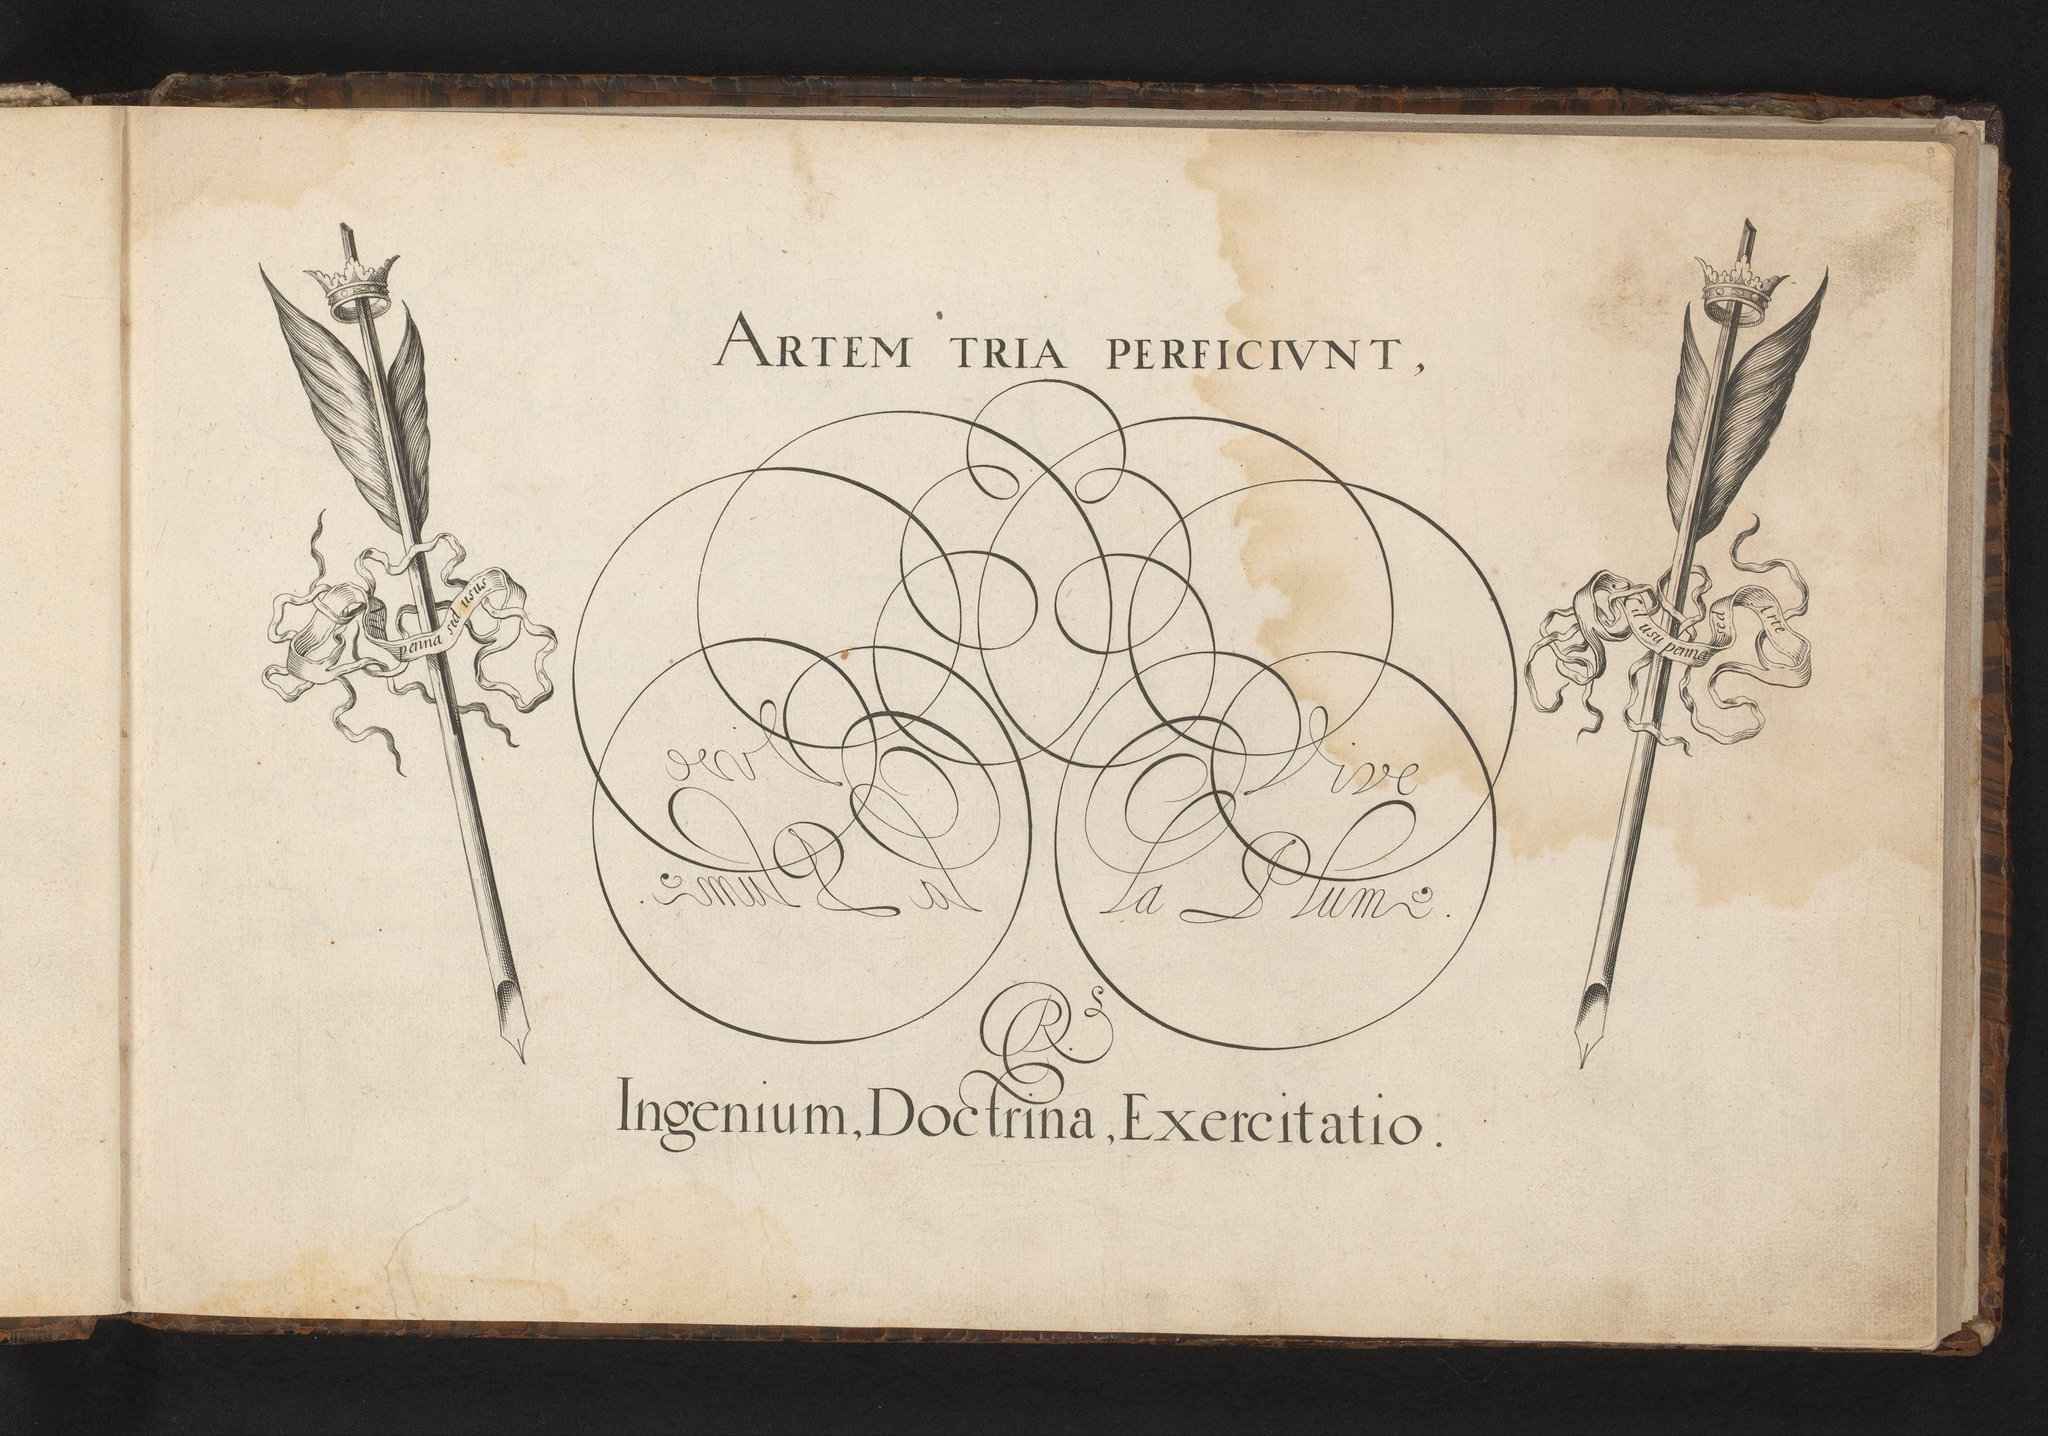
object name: ornament print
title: 't Magazin oft pac-huys der loffelycker penn-const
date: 1616-1617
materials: paper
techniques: engraving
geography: flushing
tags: quill, calligraphy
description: Twee gekroonde ganzenpennen met een banderol waarop de teksten 'Nil penna sed usus' en 'Nil usu penna sed arte'. In het midden in kalligrafie twee keer de tekst: Vive la Plume. De prent maakt deel uit van een album.